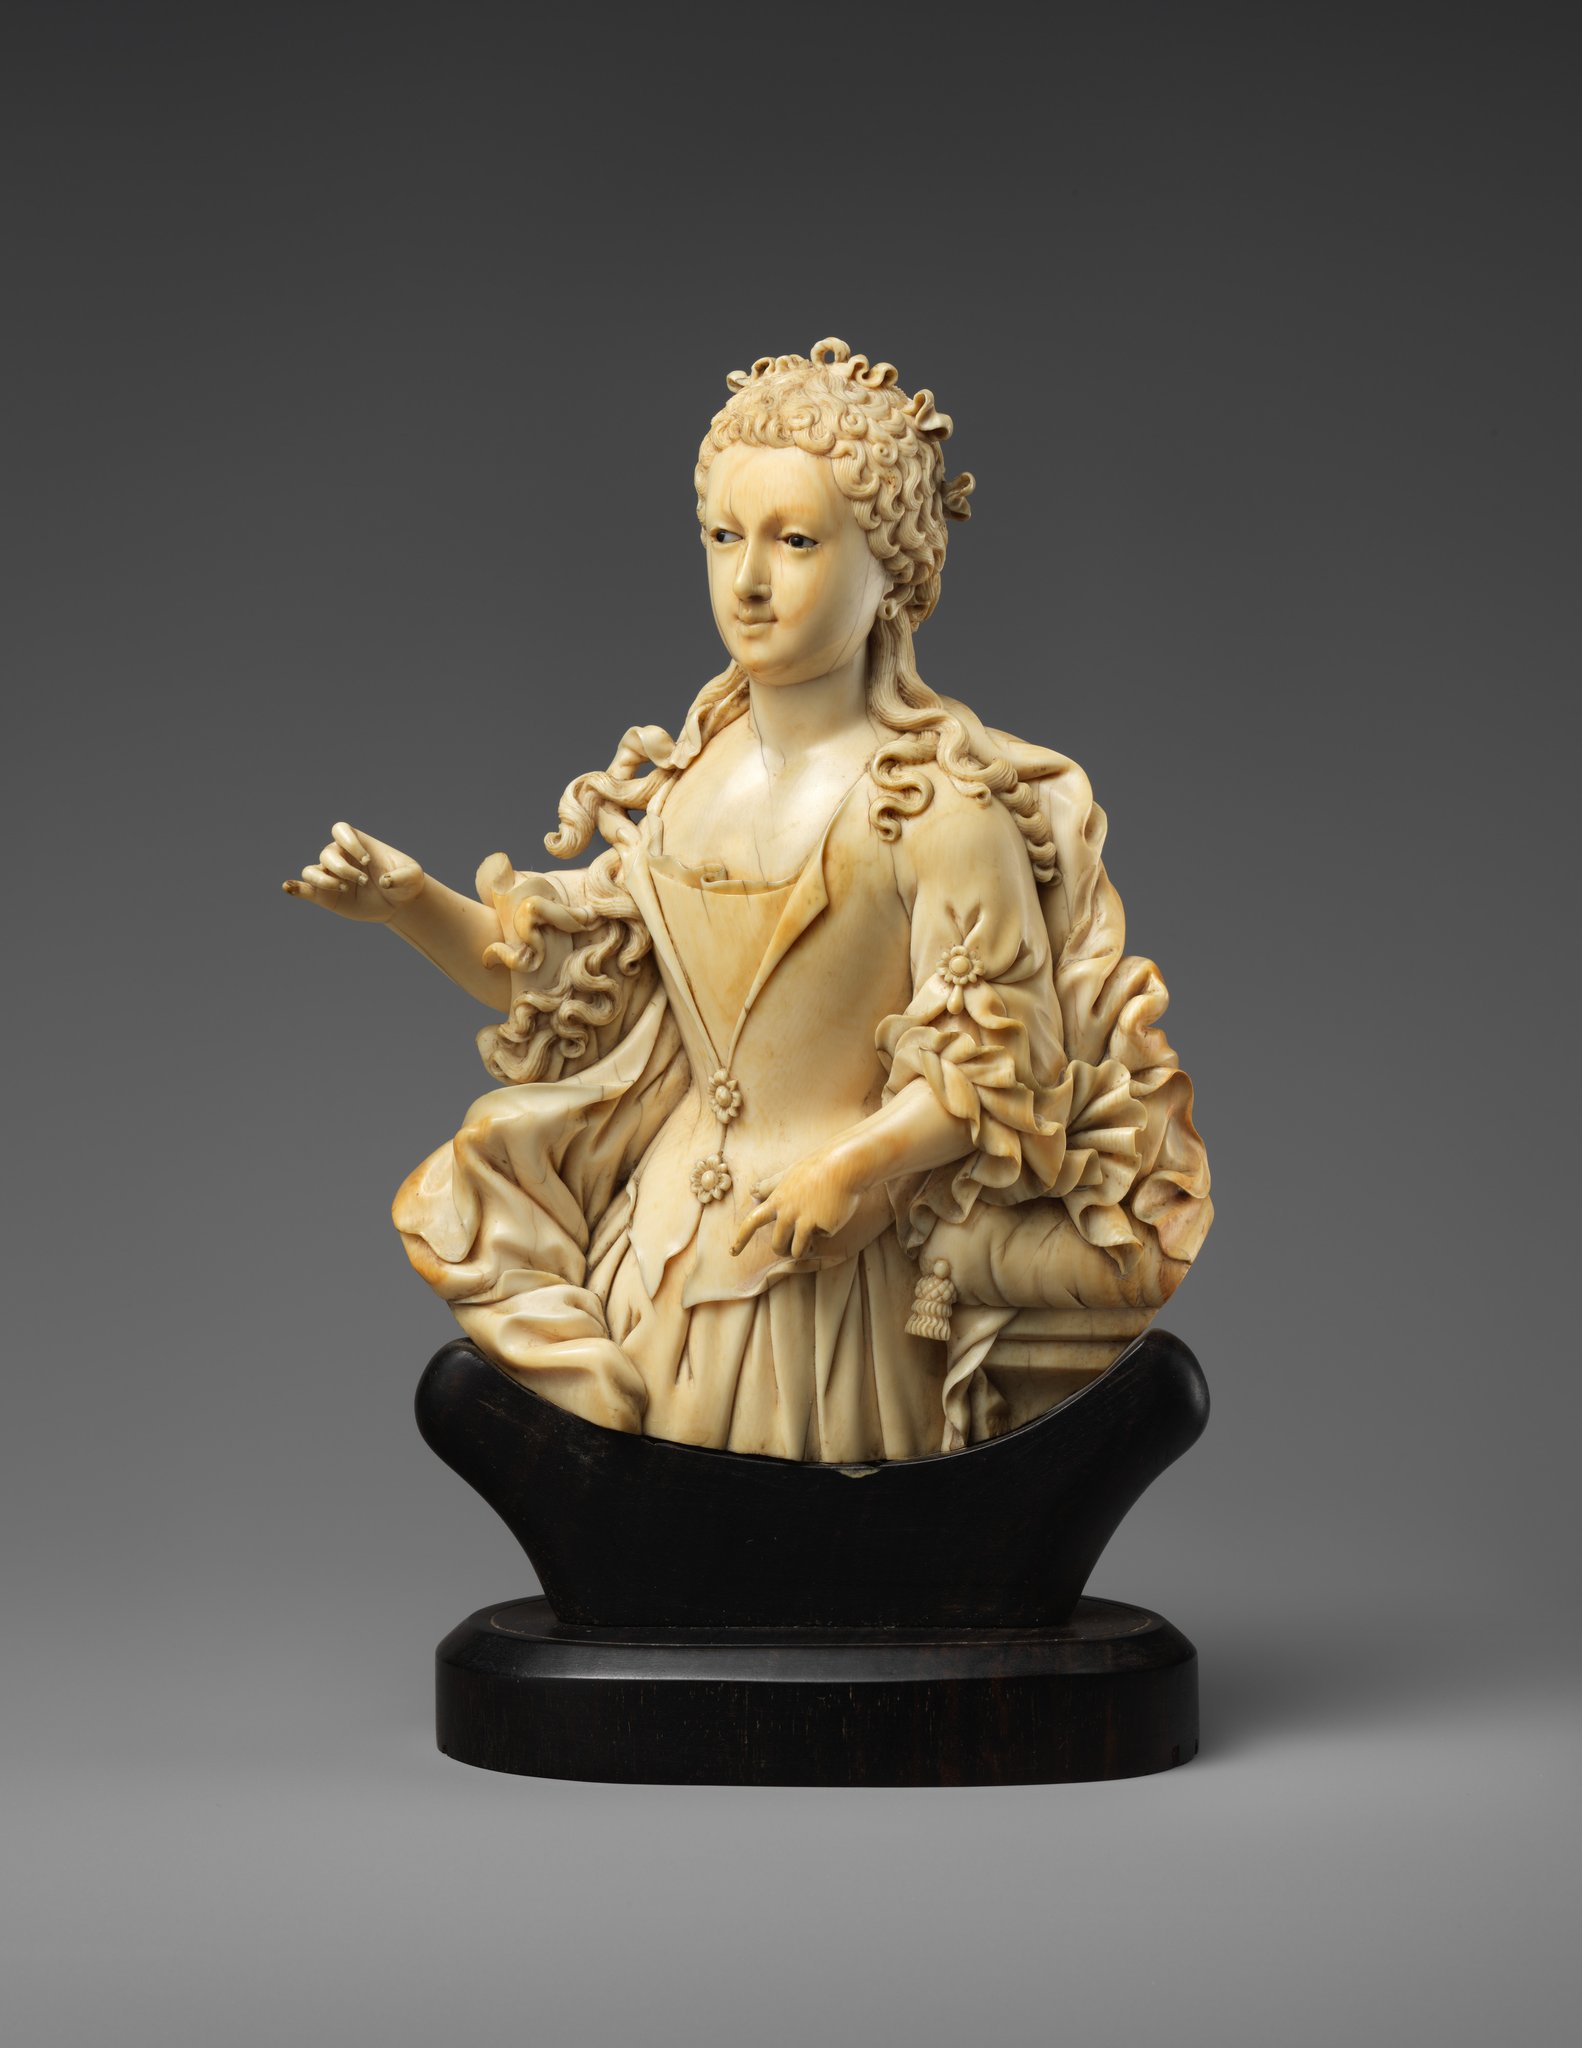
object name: bust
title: Barbara de Braganza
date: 1701-1800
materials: wood, ivory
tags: portraits,women